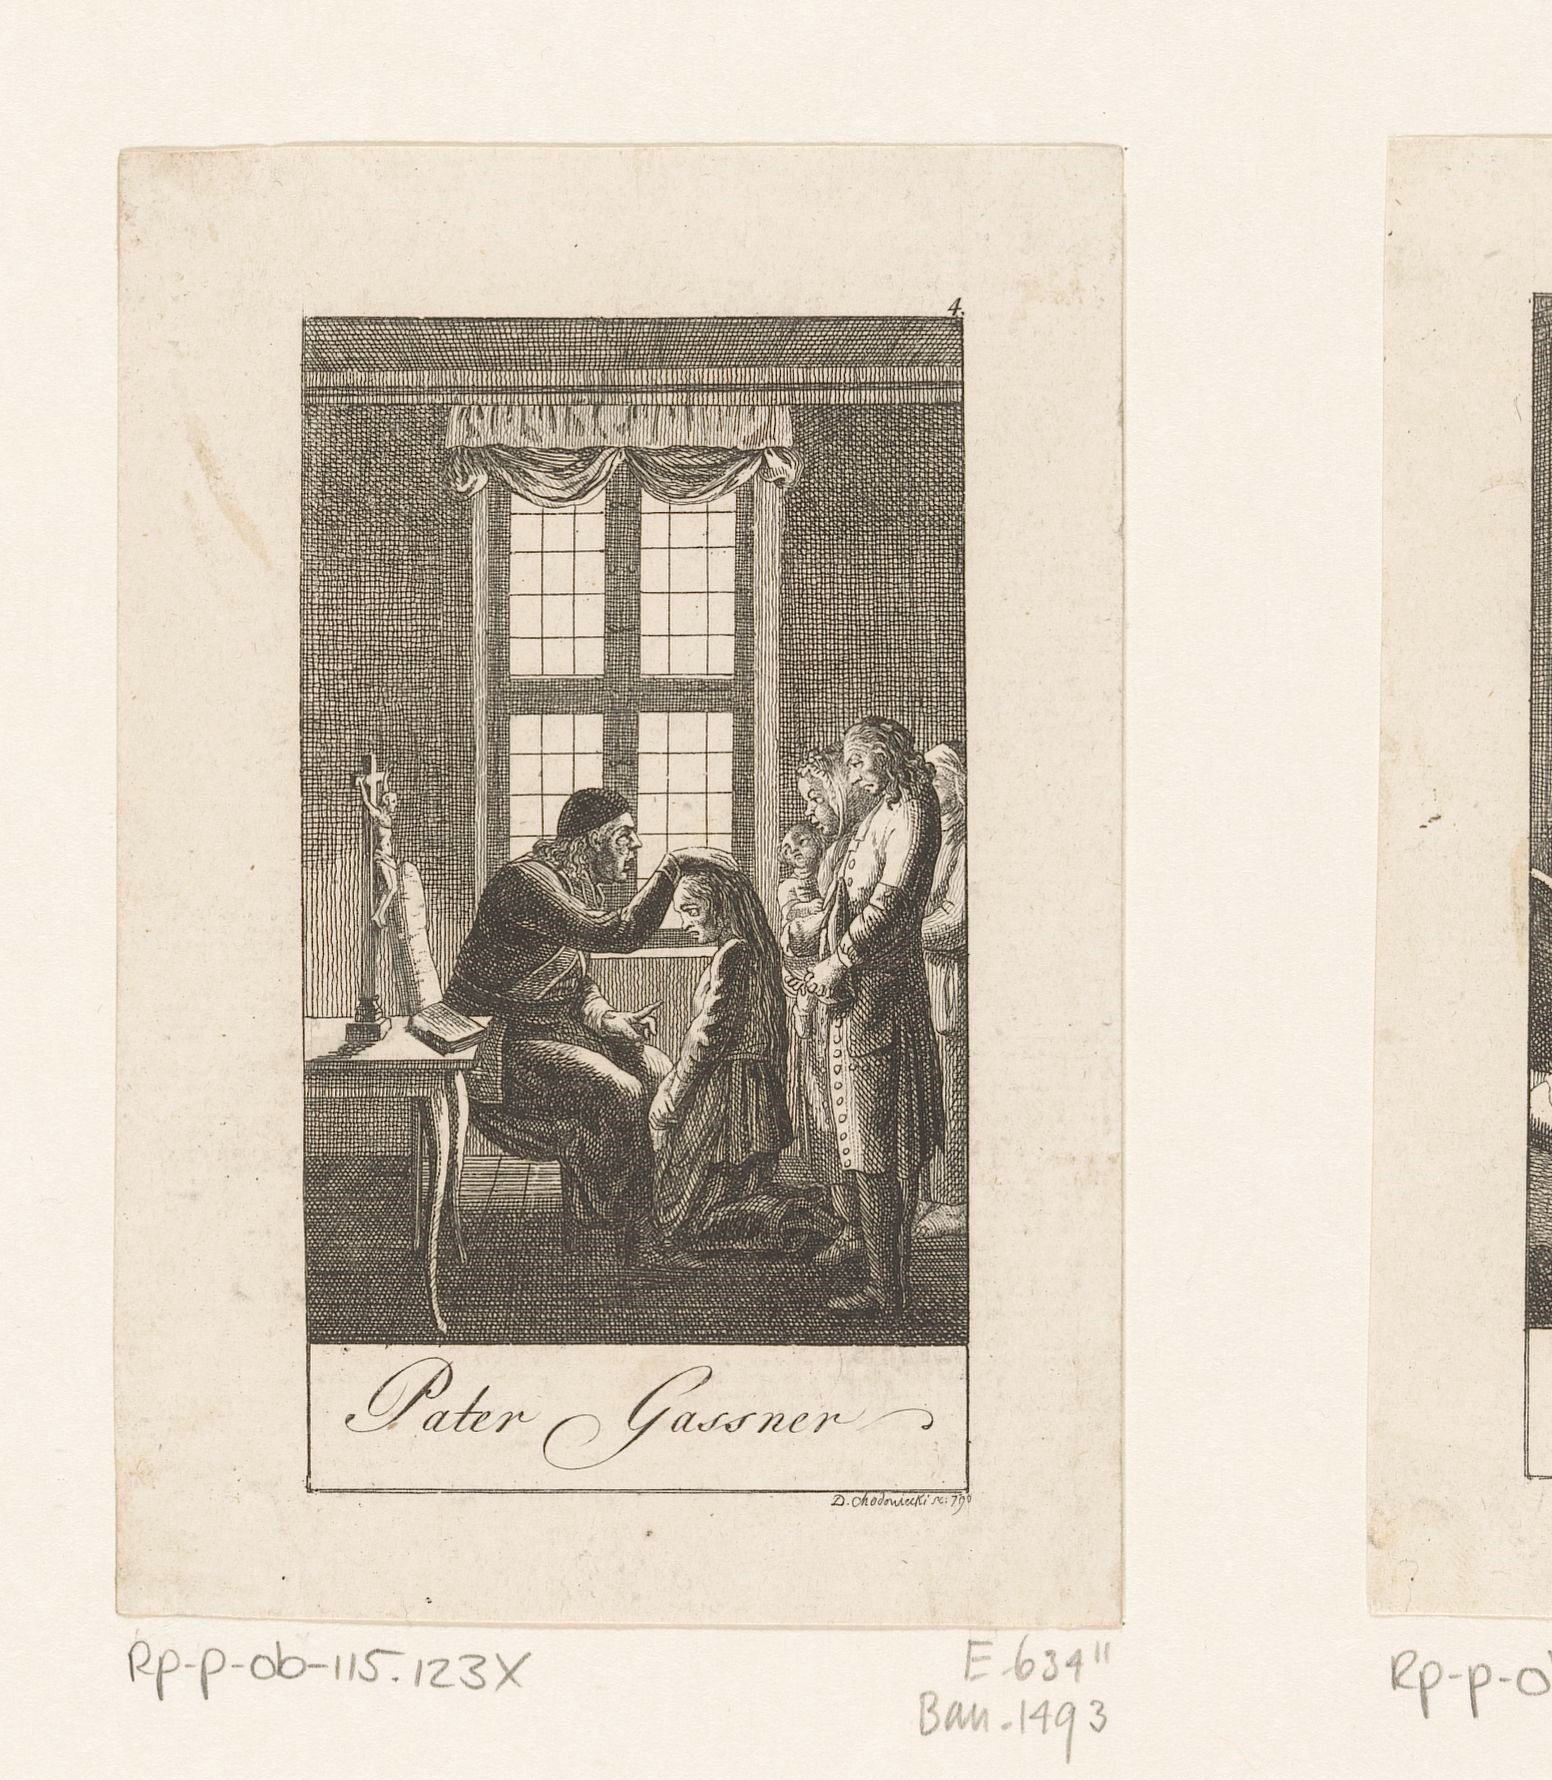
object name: print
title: Exorcisme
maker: daniel nikolaus chodowiecki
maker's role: draughtsman, print maker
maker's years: 1726-1801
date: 1790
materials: paper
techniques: etching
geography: berlin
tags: adolescent, young woman, maiden, exorcizing the devil, priests ~ hierarchy of priests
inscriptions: collector's mark: Lugt 2228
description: Prent gebruikt voor: Taschenbuch für Aufklärer und Nichtaufklärer auf das Jahr 1791. Berlijn: Johann Friedrich Unger, [1790].